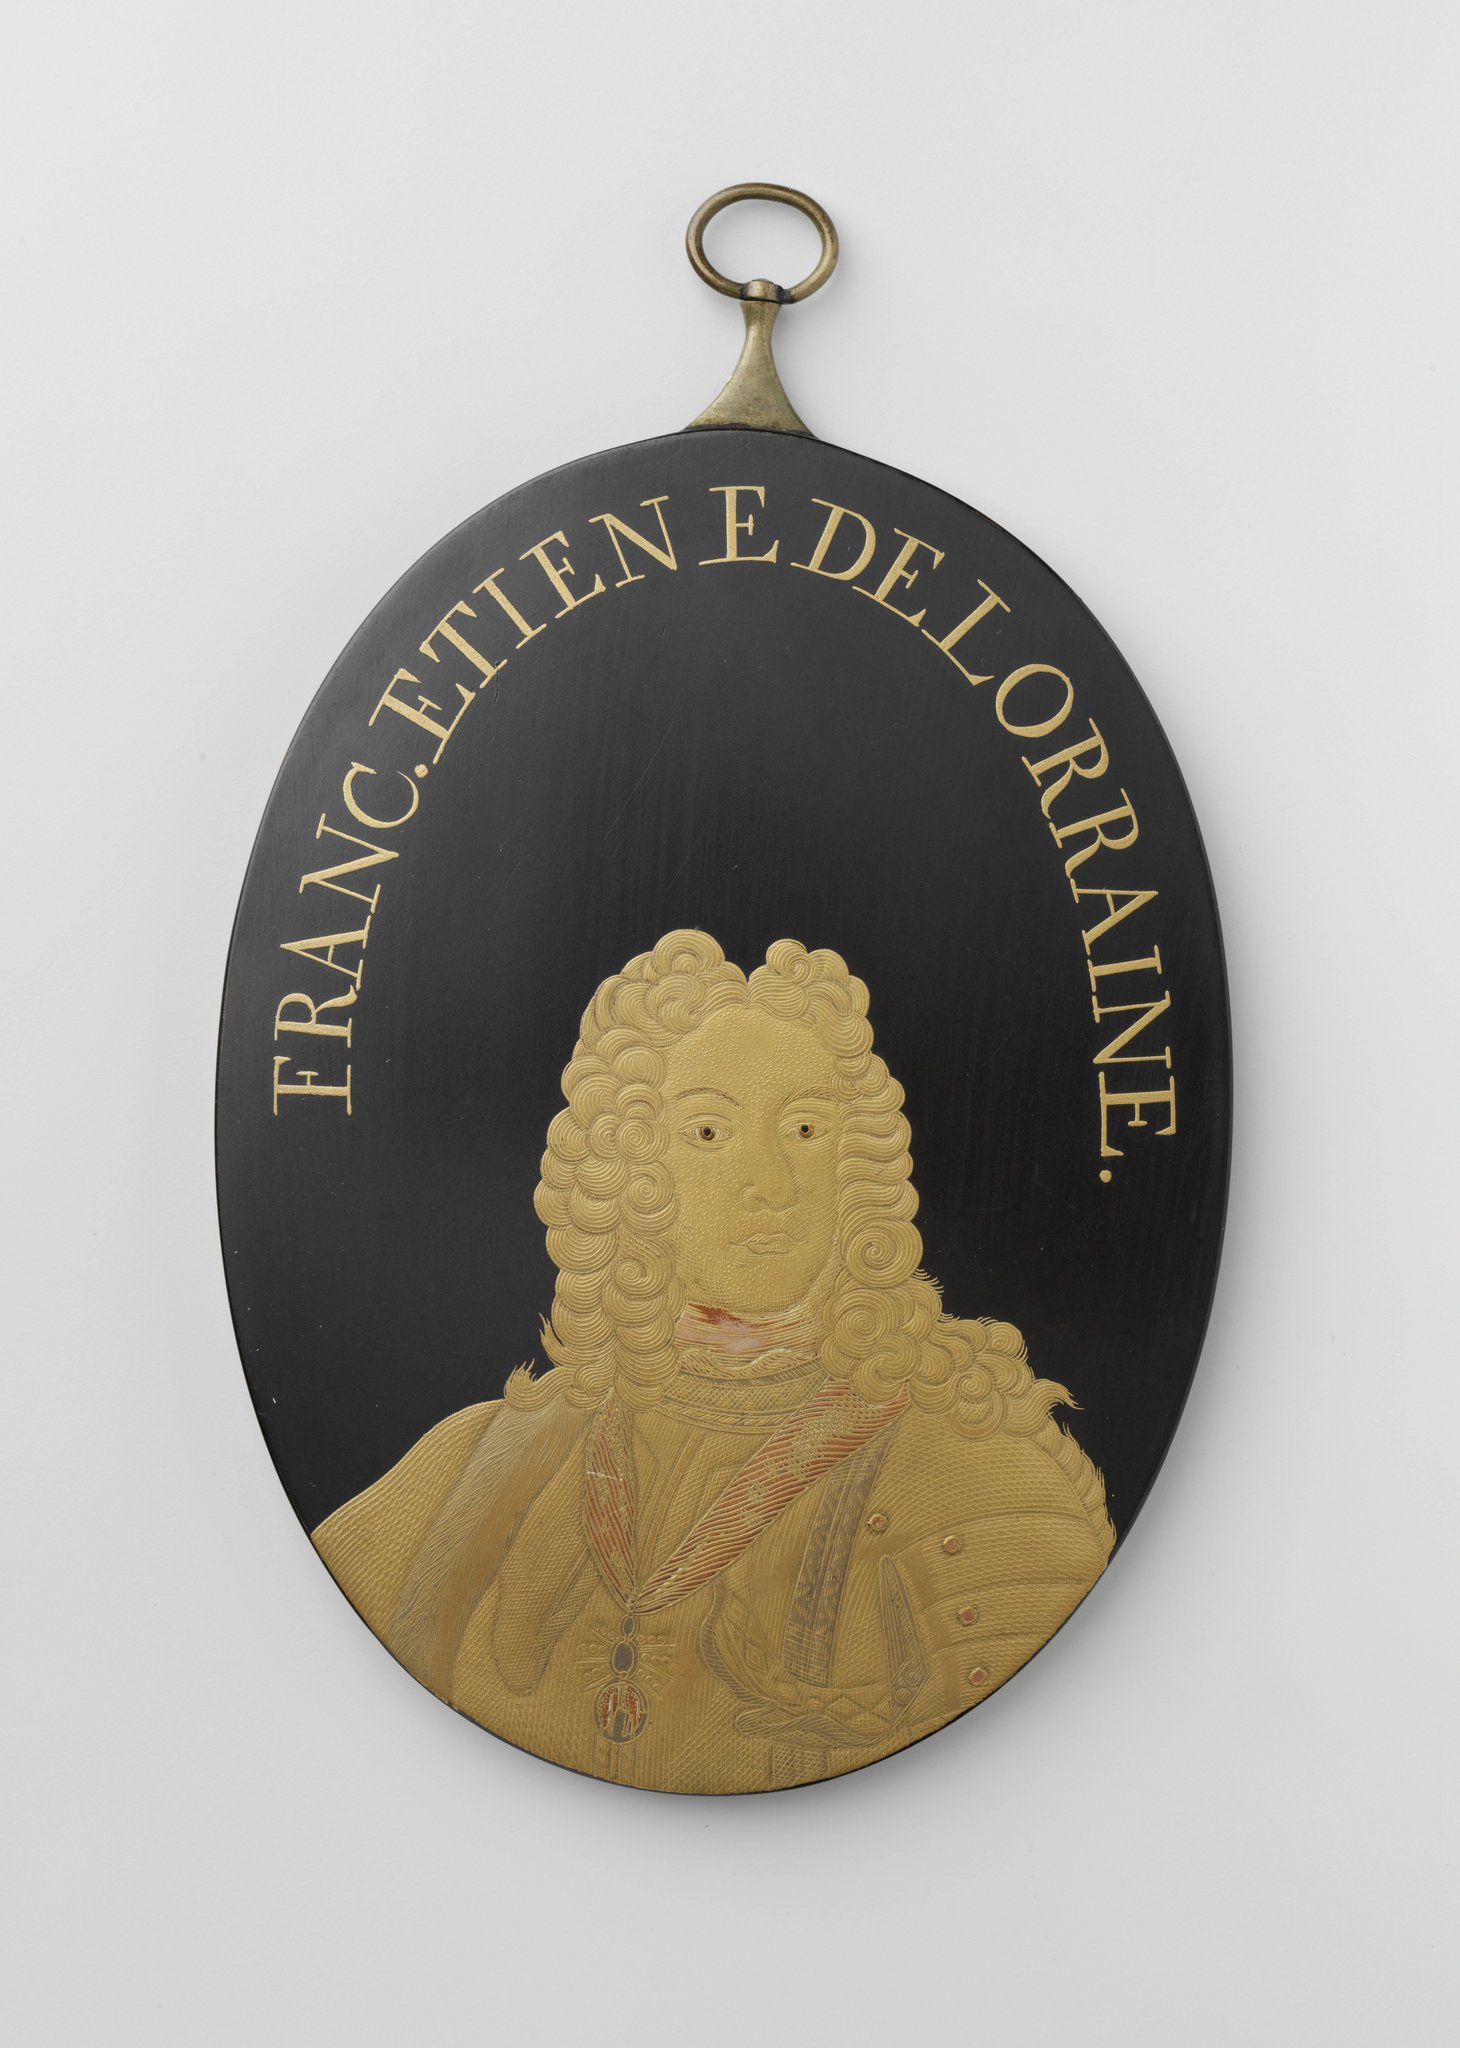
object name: plaque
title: Francois Etienne de Lorraine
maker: Anonymous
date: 1775-1800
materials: copper, lacquer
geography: japan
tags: frans i stefan (duits keizer)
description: Portraits of European monarchs and scholars. Japan, last quarter 18th century. The VOC exported lacquer products commissioned specifically for the European market. Working from European prints, Japanese craftsmen made series of portraits for the VOC.